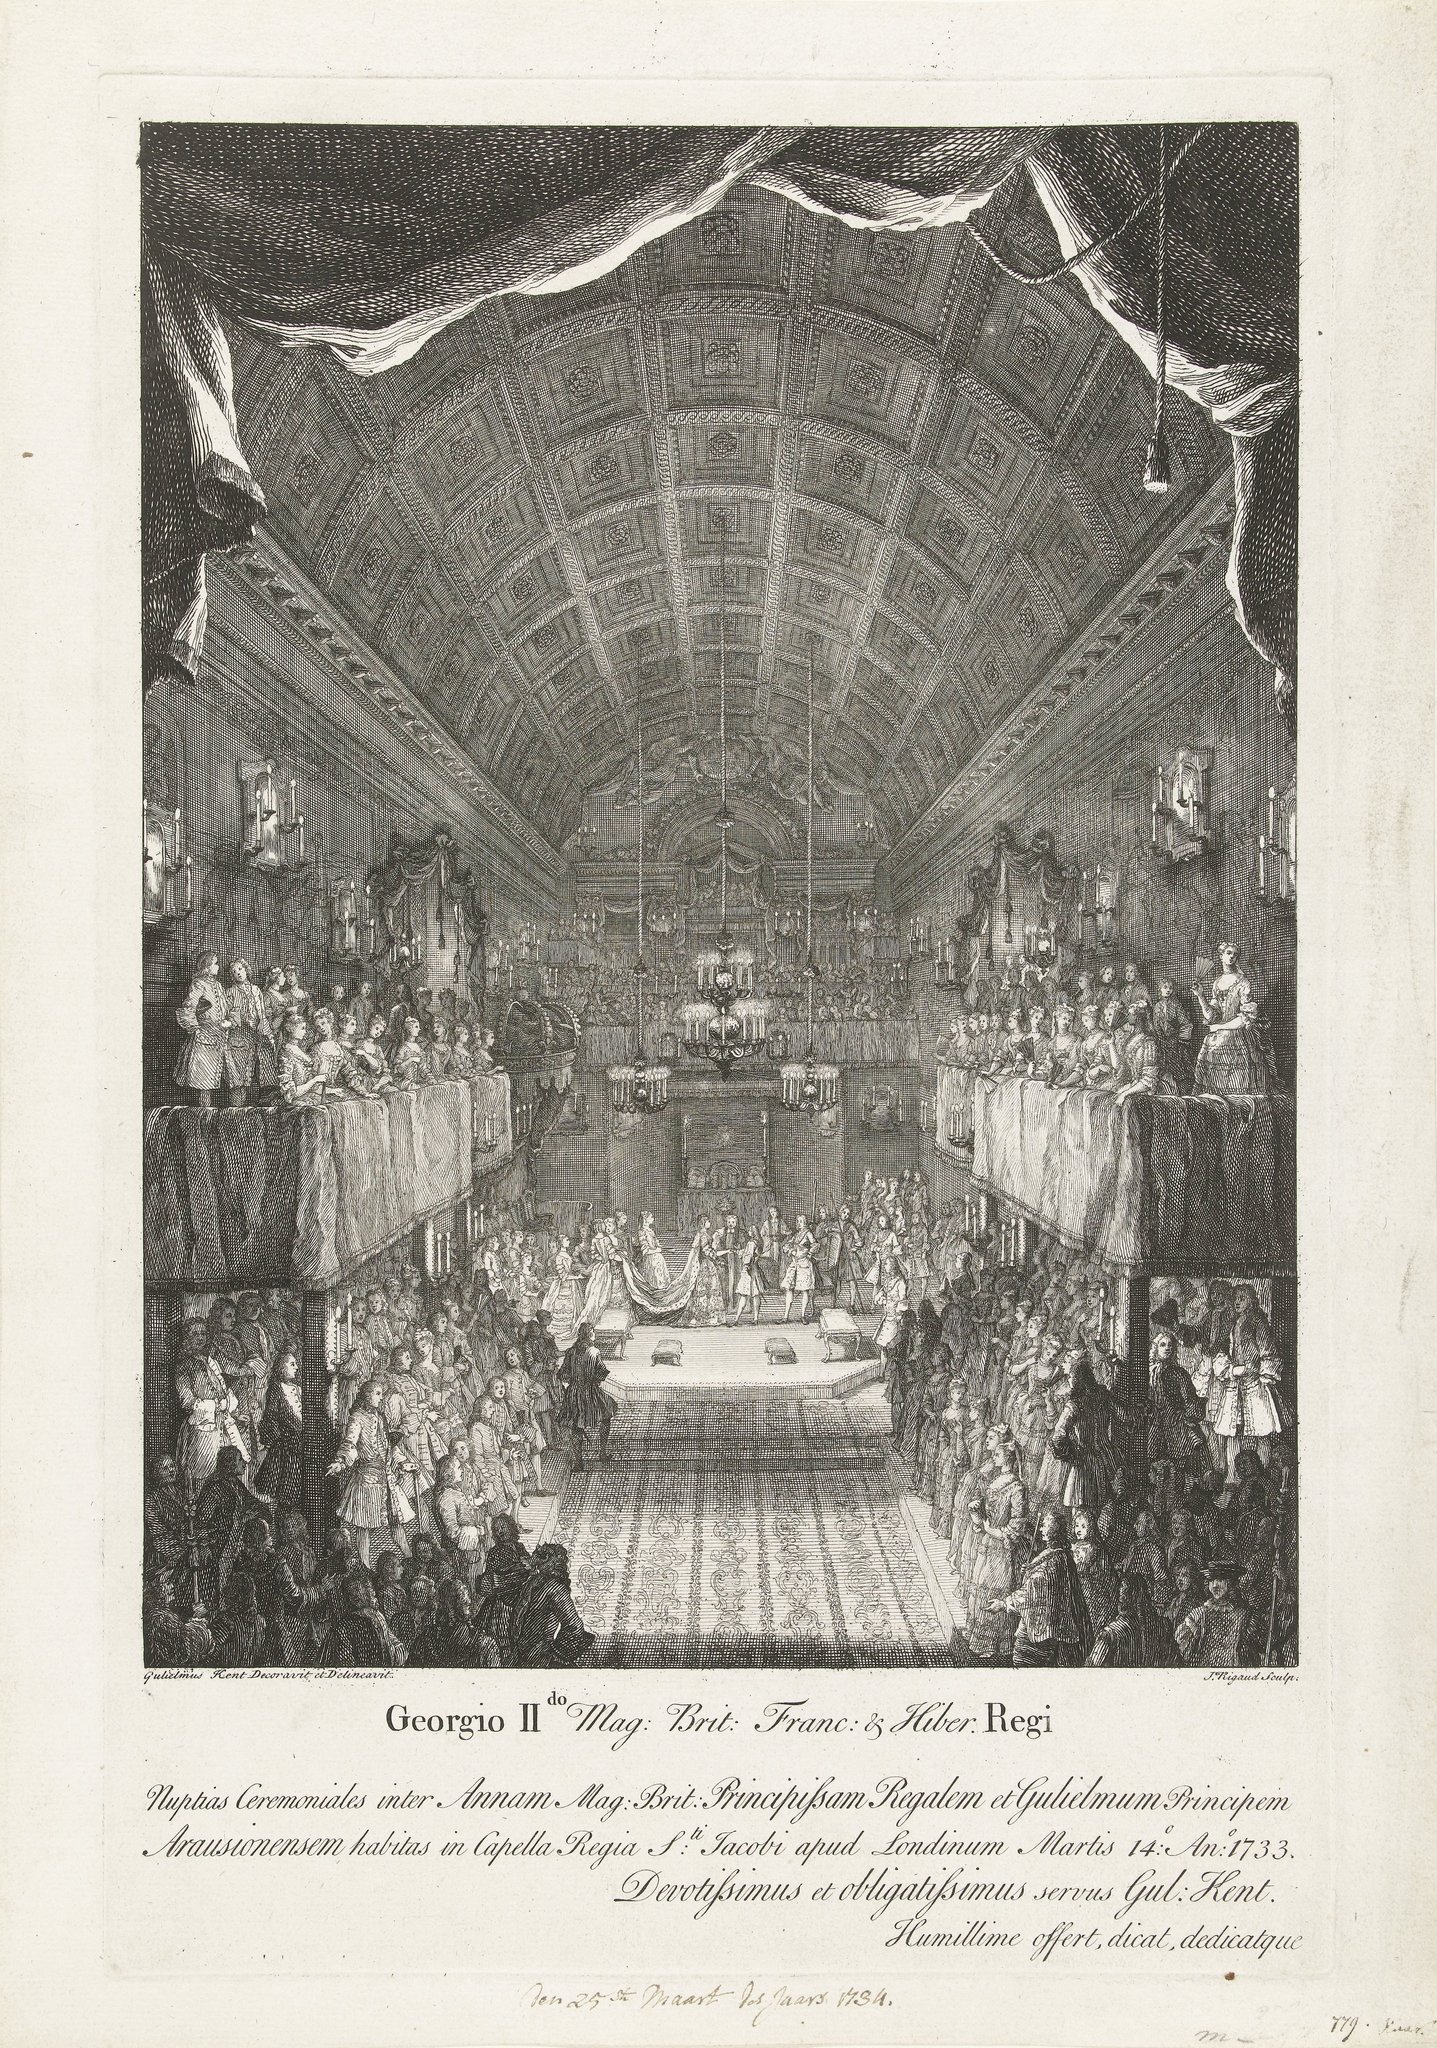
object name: print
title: Huwelijk van Willem IV met prinses Anna, 1734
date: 1734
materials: paper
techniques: etching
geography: france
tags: willem iv (prins van oranje-nassau), anna van hannover, (civil) marriage ceremonies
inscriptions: collector's mark: Lugt 2166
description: De huwelijksceremonie van prins Willem IV met de Engelse kroonprinses Anna, dochter van koning George II van Engeland, in de kapel van St. James's Palace te Londen op 25 maart 1734.